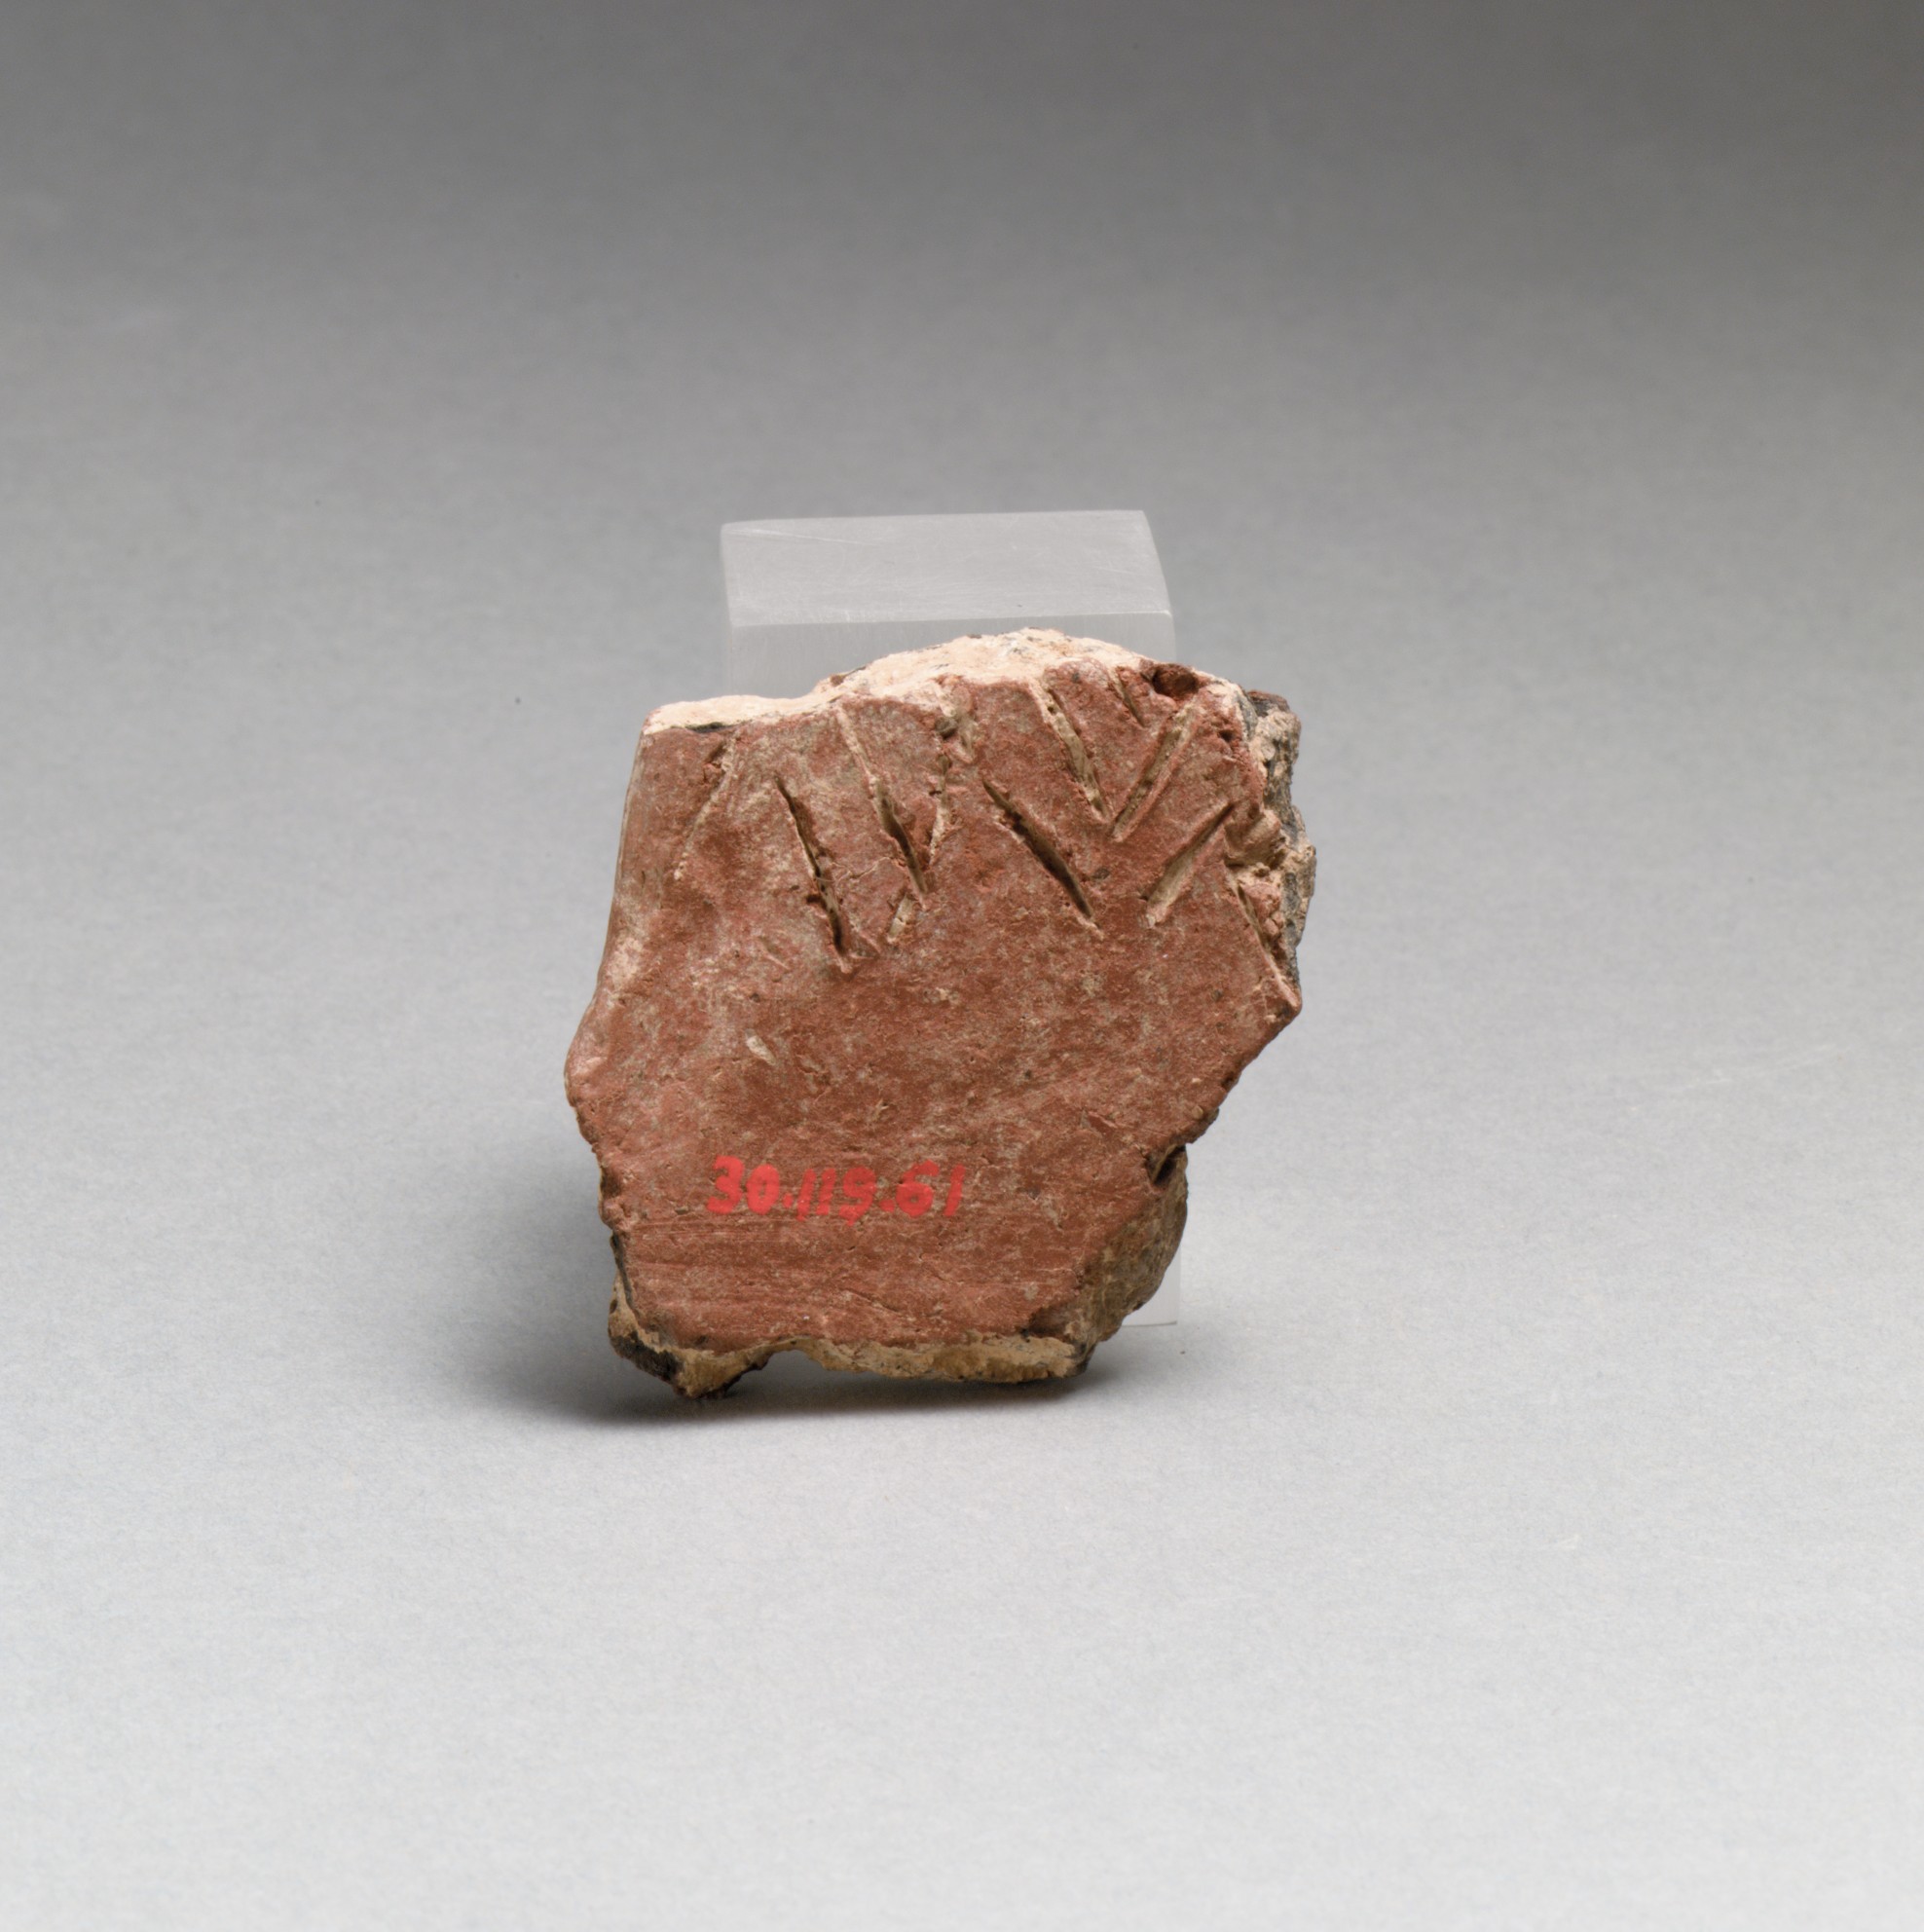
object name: vase fragment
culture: neolithic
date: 4000-3000 BCE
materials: terracotta